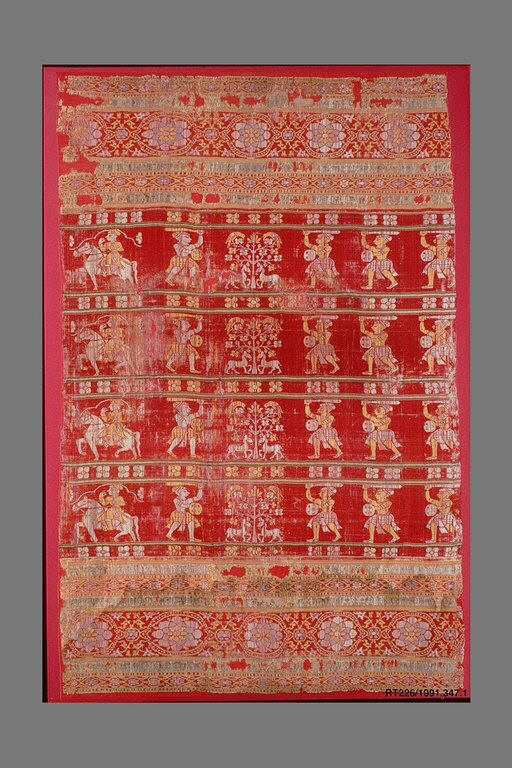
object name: textile fragment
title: Part of a Hanging or Curtain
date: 1600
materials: silk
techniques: satin weave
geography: india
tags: men,horses